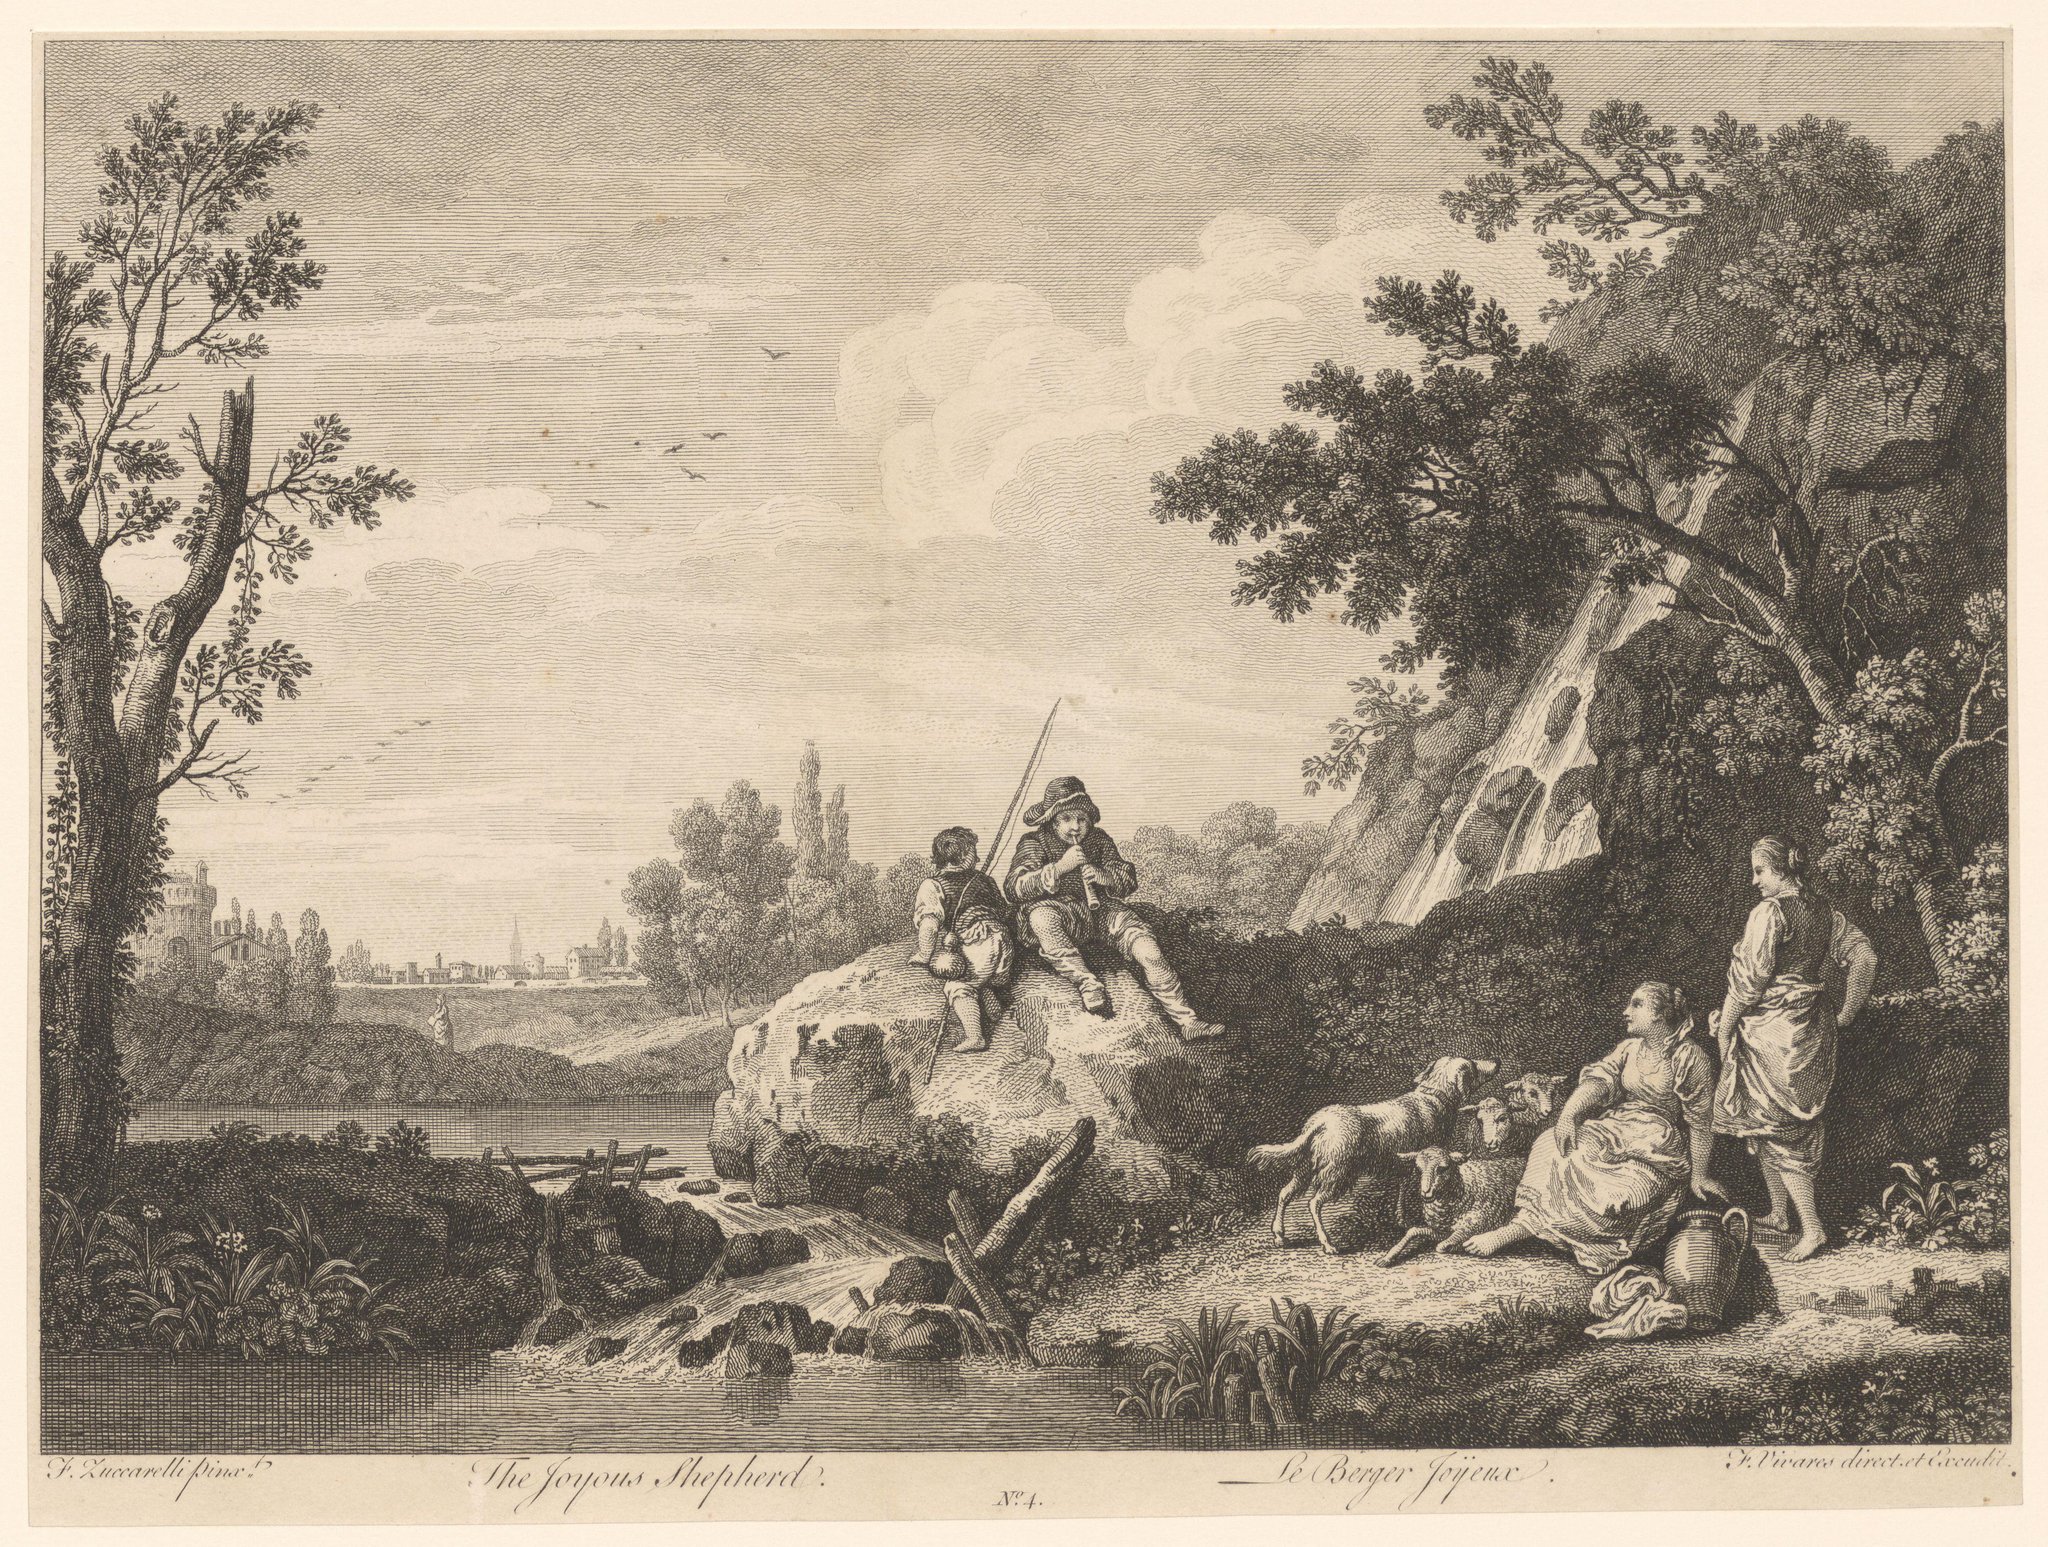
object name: print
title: The Joyous Shepherd / Le Berger Joijeux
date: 1719-1780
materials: paper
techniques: etching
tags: herding, herdsman, herdswoman, shepherd, shepherdess, cowherd, etc., (traveller) resting in the open air, waterfall (+ landscape with figures, staffage)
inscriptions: collector's mark: Lugt 2228